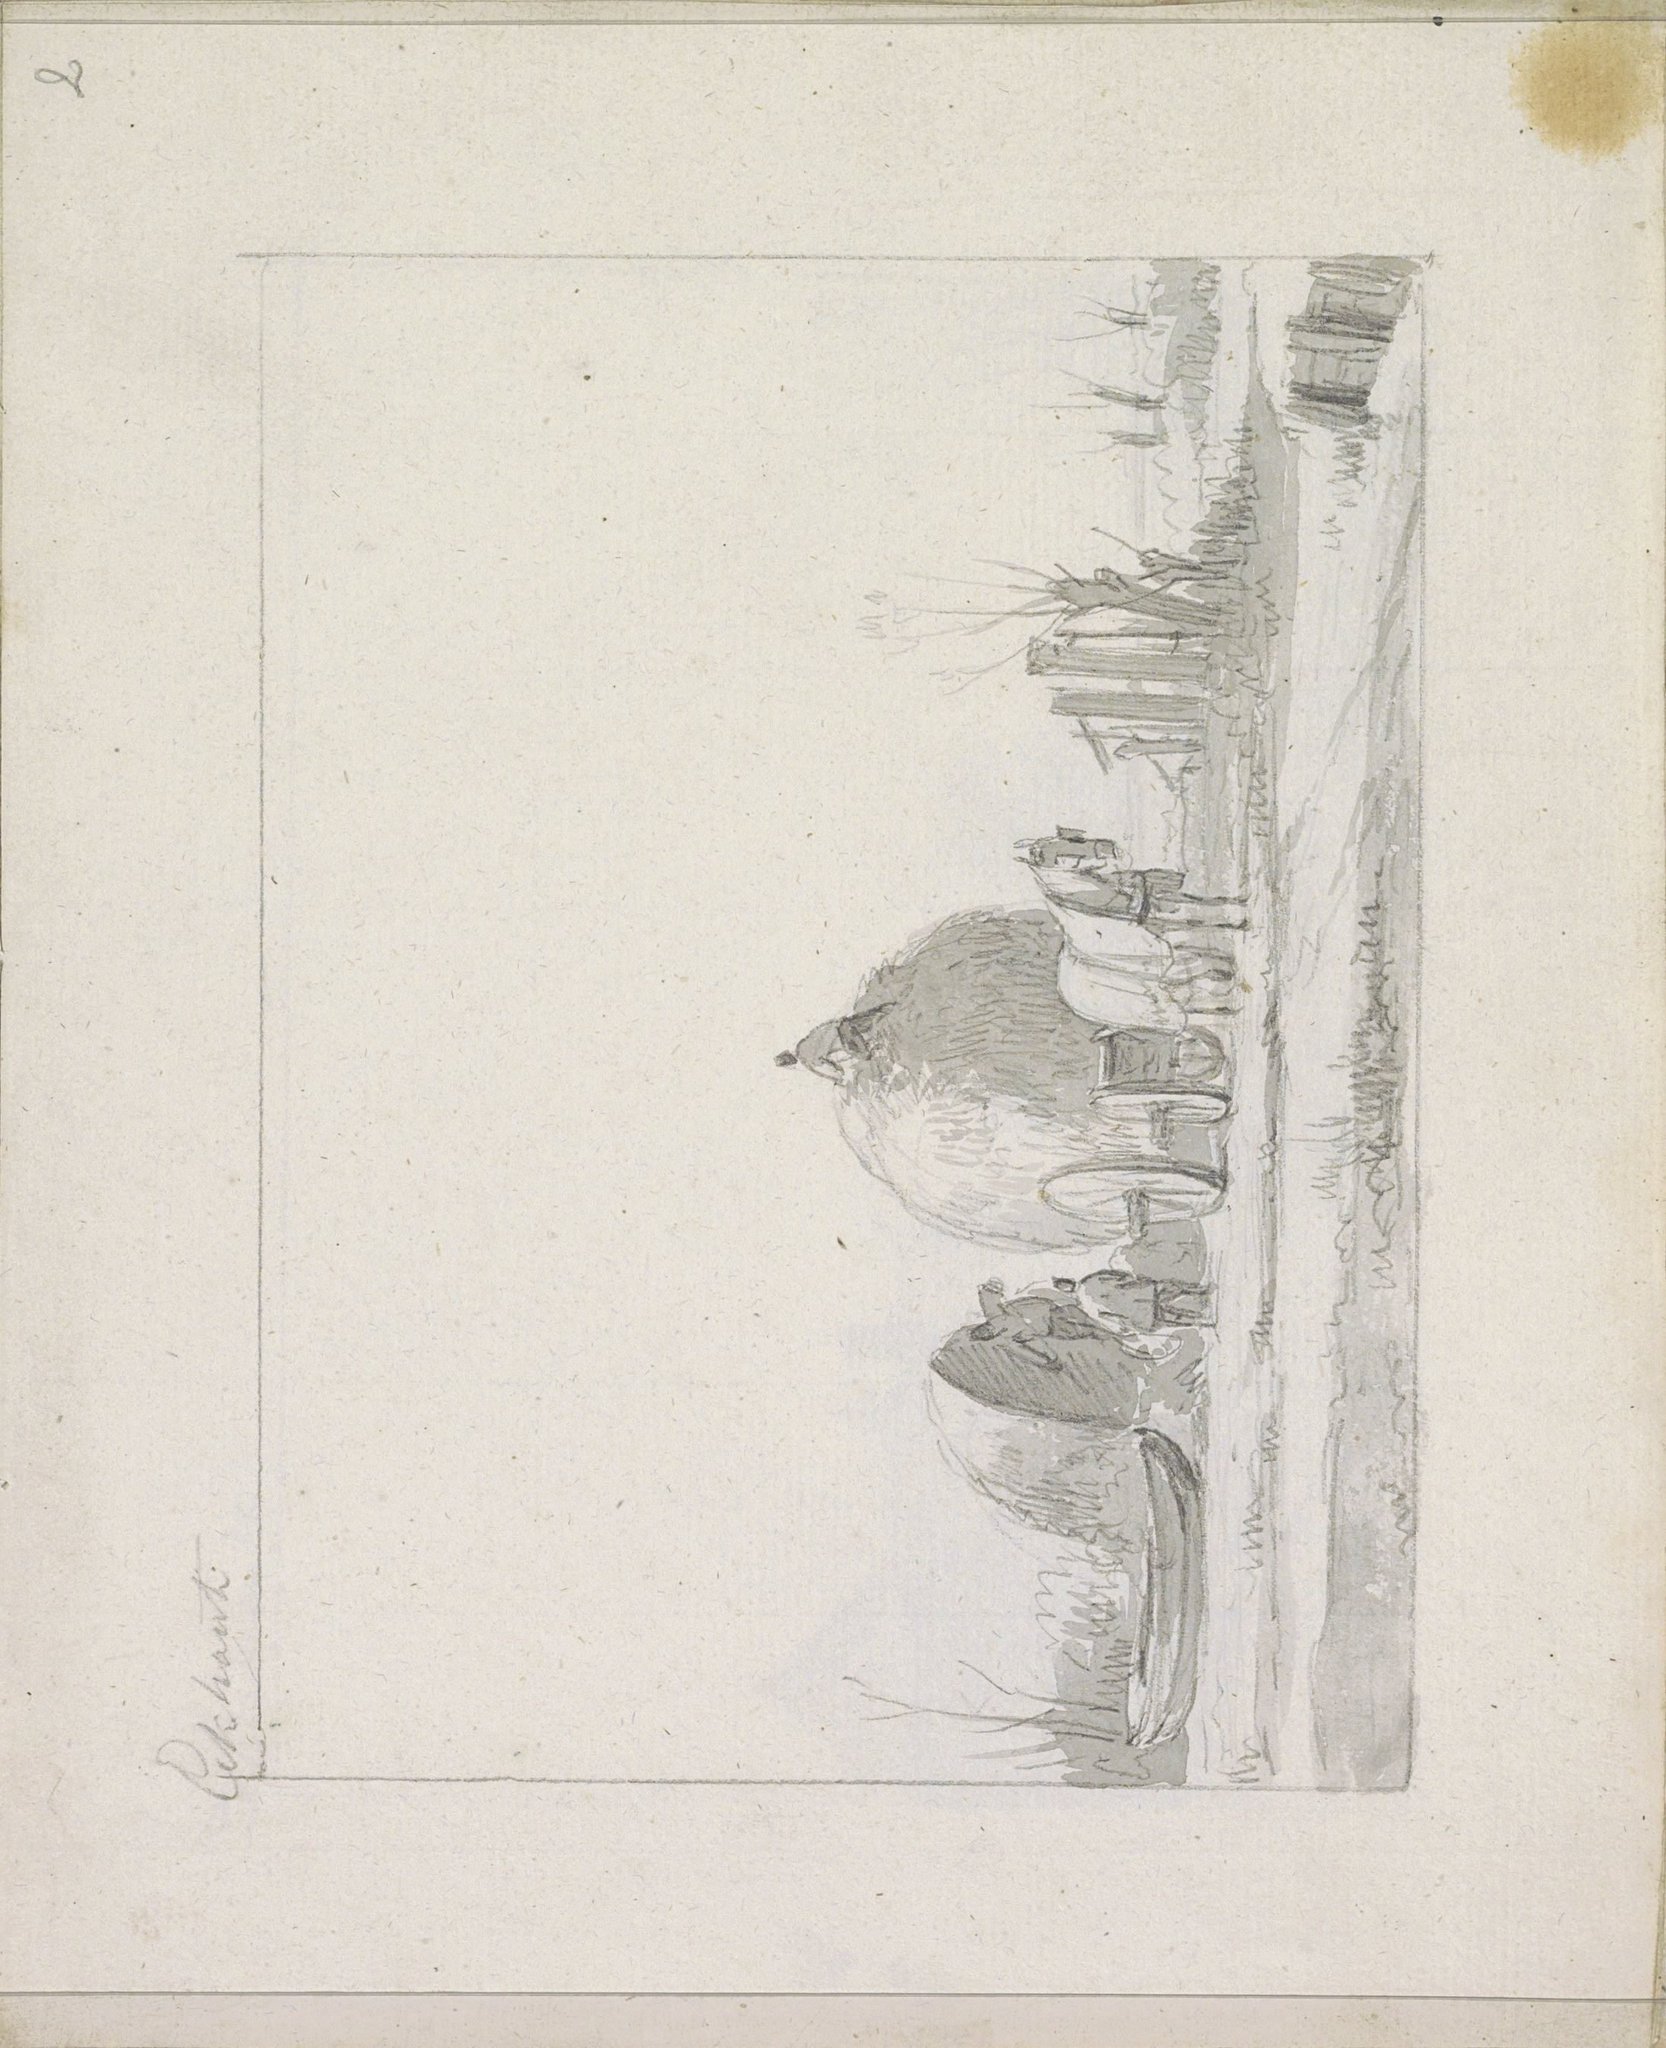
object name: sketchbook leaf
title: Paardenkar en figuren bij hooioppers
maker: andreas schelfhout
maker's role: draughtsman, painter, print maker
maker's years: 1787-1870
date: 1825-1829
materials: paper, pencil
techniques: brush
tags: hay-stack, landscapes (+ landscape with figures, staffage)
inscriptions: number: ‘2’, annotation: ‘Eekhout’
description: Blad 6 recto uit een schetsboek met 95 bladen.